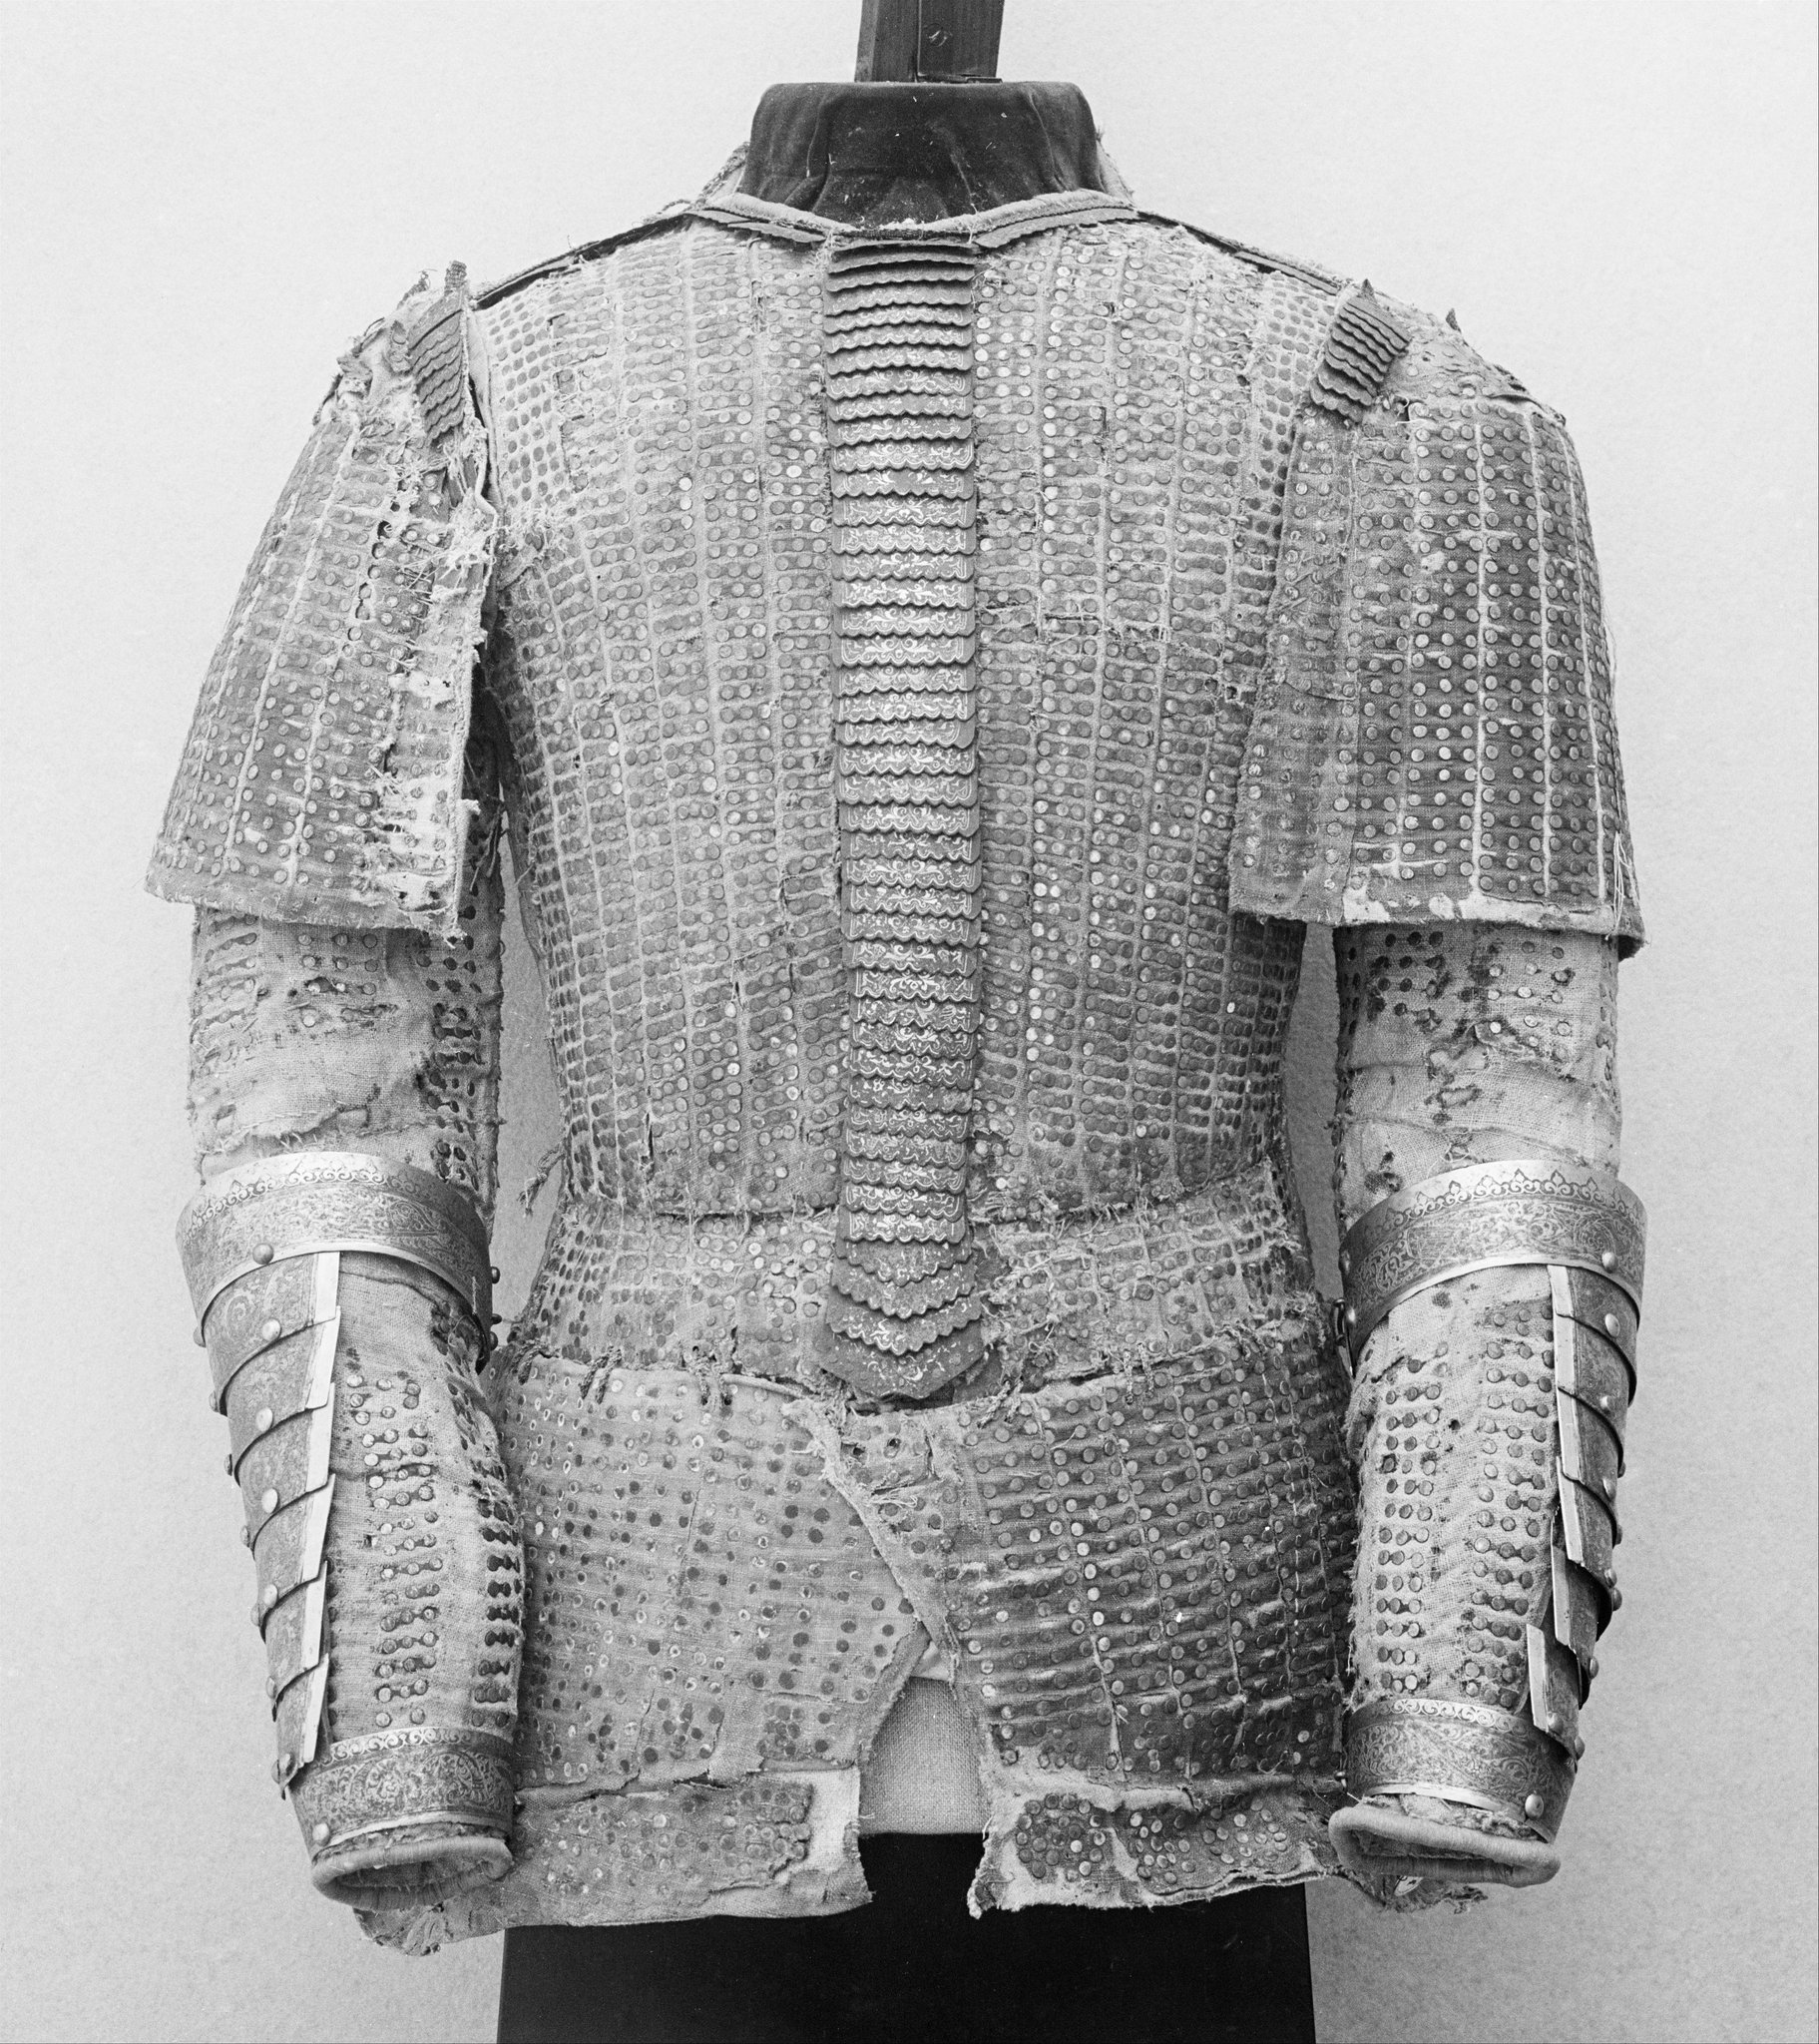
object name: brigandine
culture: italian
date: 1550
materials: gold, linen, silver, steel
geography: italy